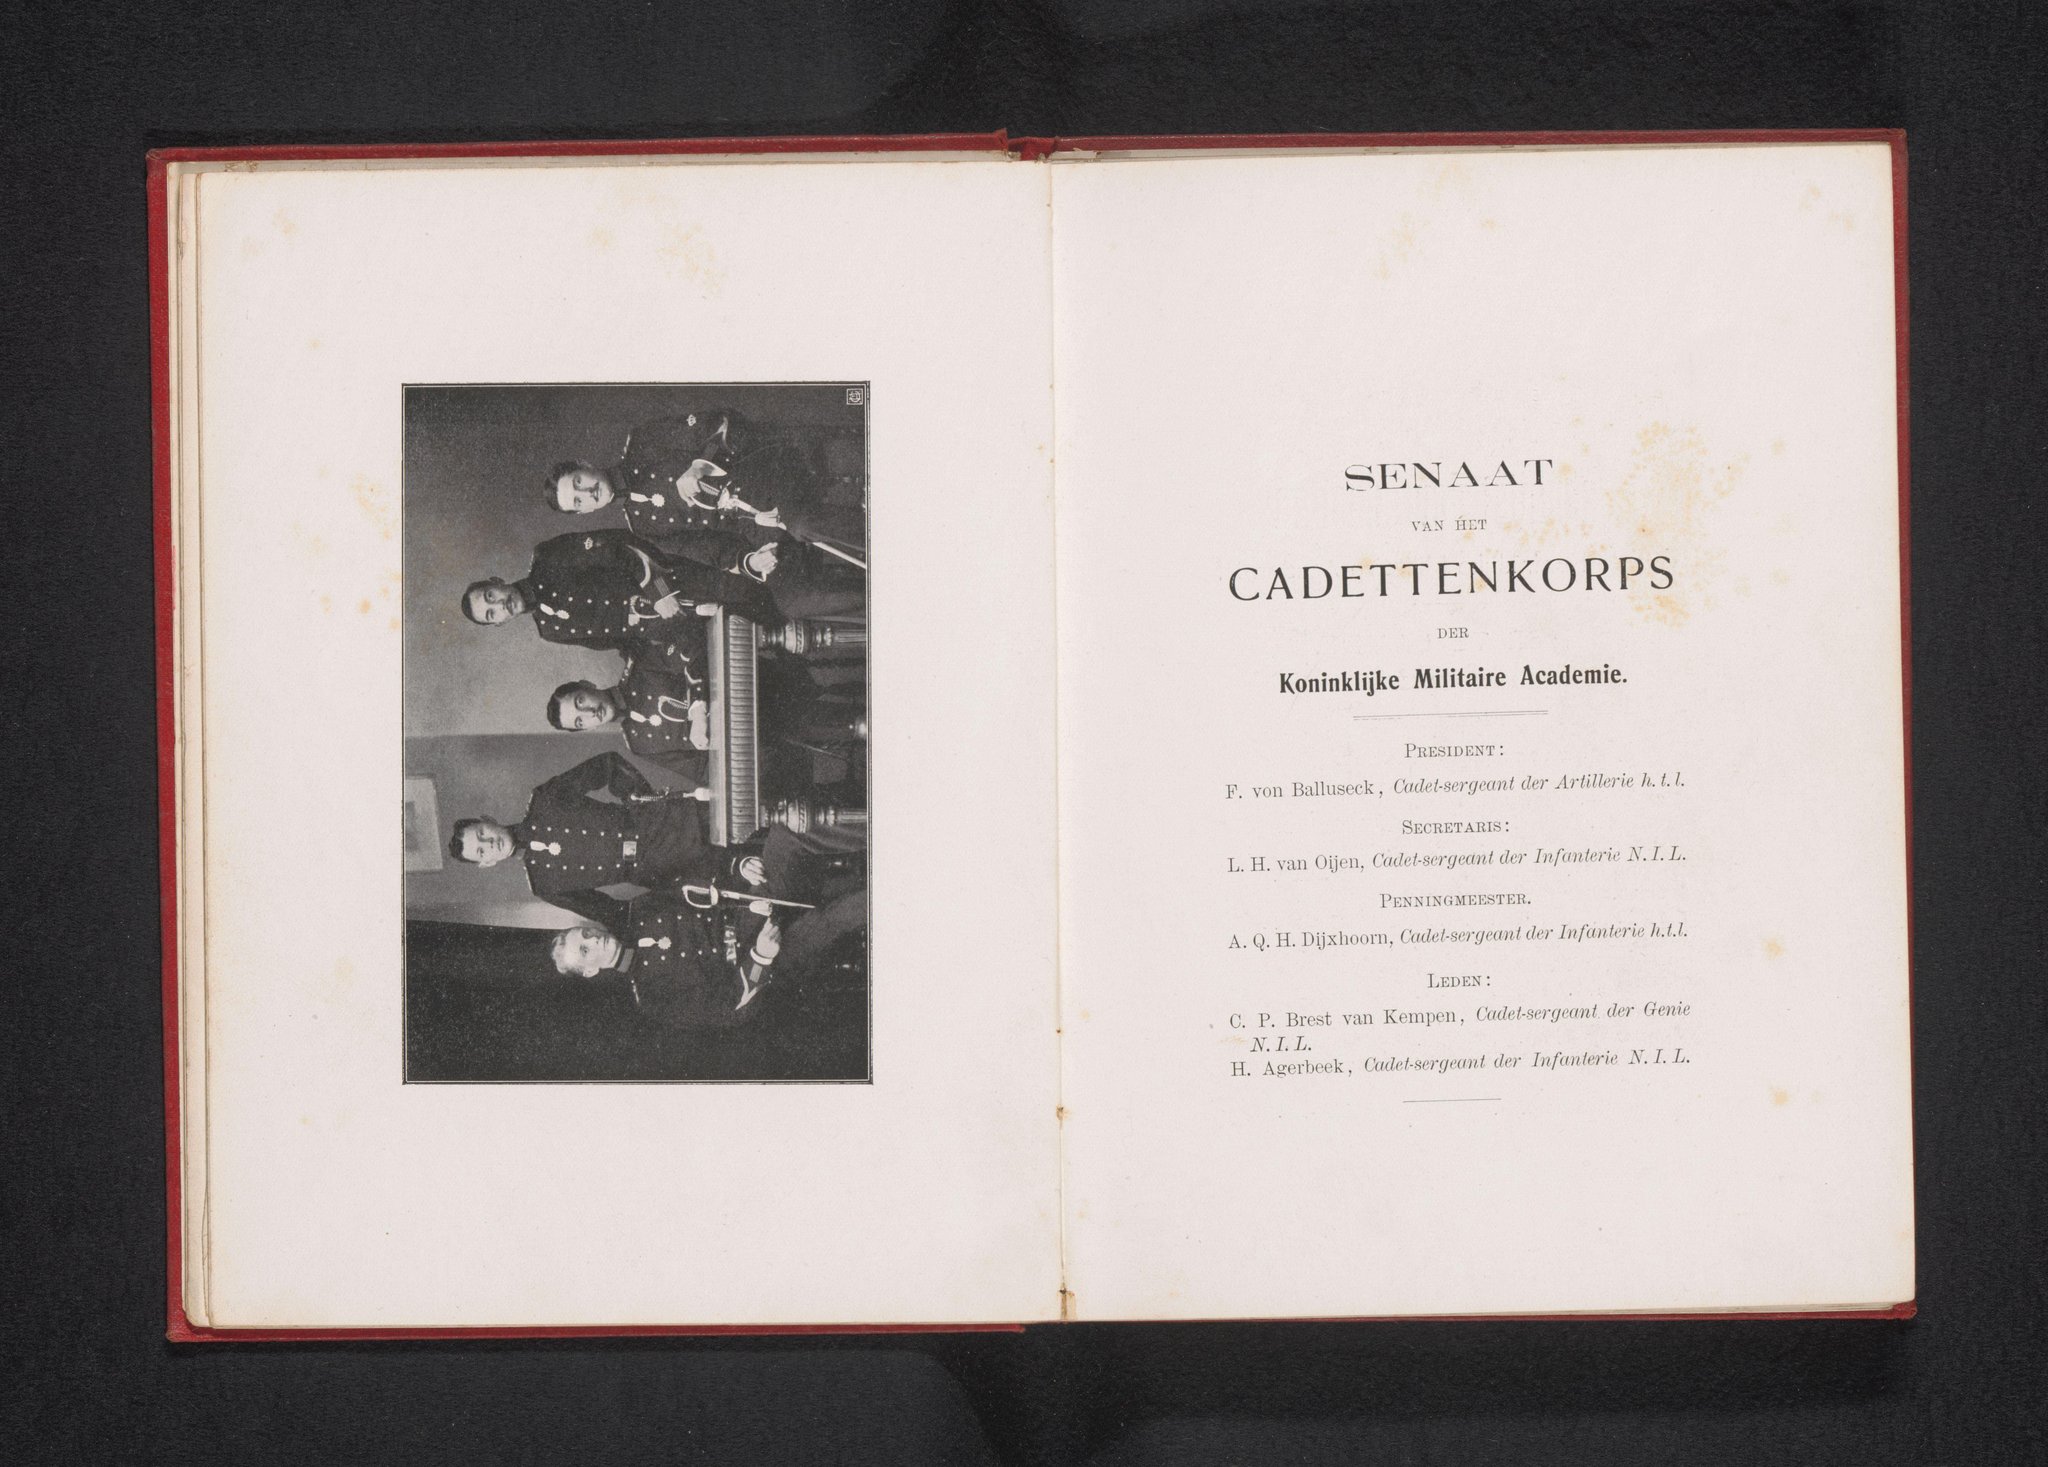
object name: page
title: Groepsportret van de Senaat van het Cadettenkorps der Koninklijke Militaire Academie in Breda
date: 1905-1910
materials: paper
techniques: autotype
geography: breda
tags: anonymous historical persons portrayed in a group, in a group-portrait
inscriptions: monogram: ‘CHT’